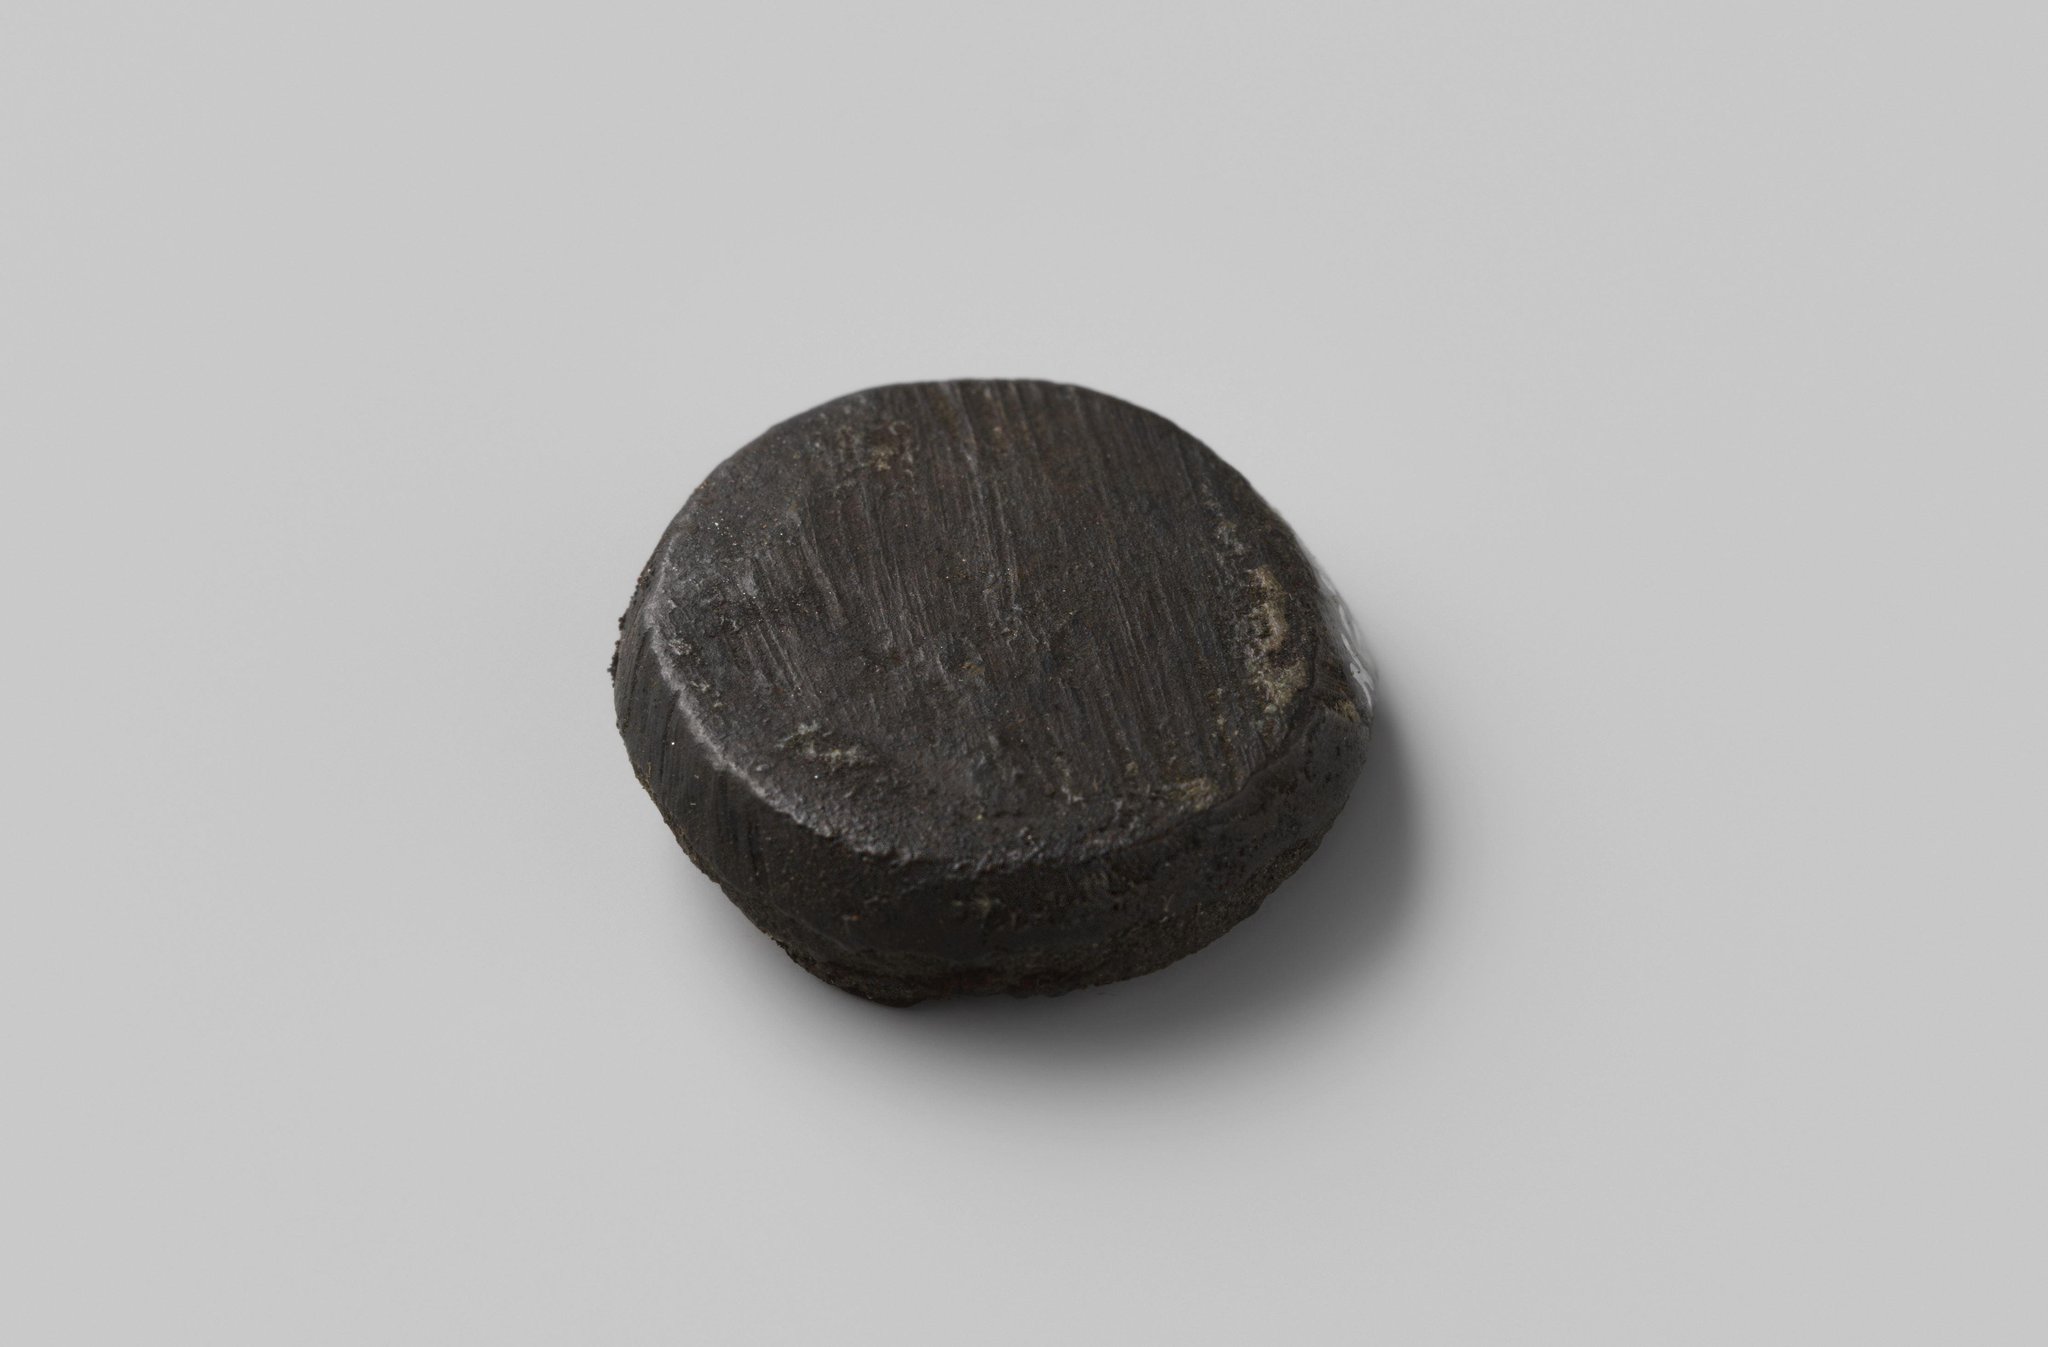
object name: bekroning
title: Bekroning of uiteinde uit het wrak van de Oost-Indiëvaarder Hollandia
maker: Anonymous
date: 1700-1743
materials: copper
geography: netherlands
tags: verenigde oostindische compagnie, hollandia (schip), annet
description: Varied parts or fragments, end or finials; fragm, eroded, circular, flat bevelled rim, underside concave with circular vertical rim.